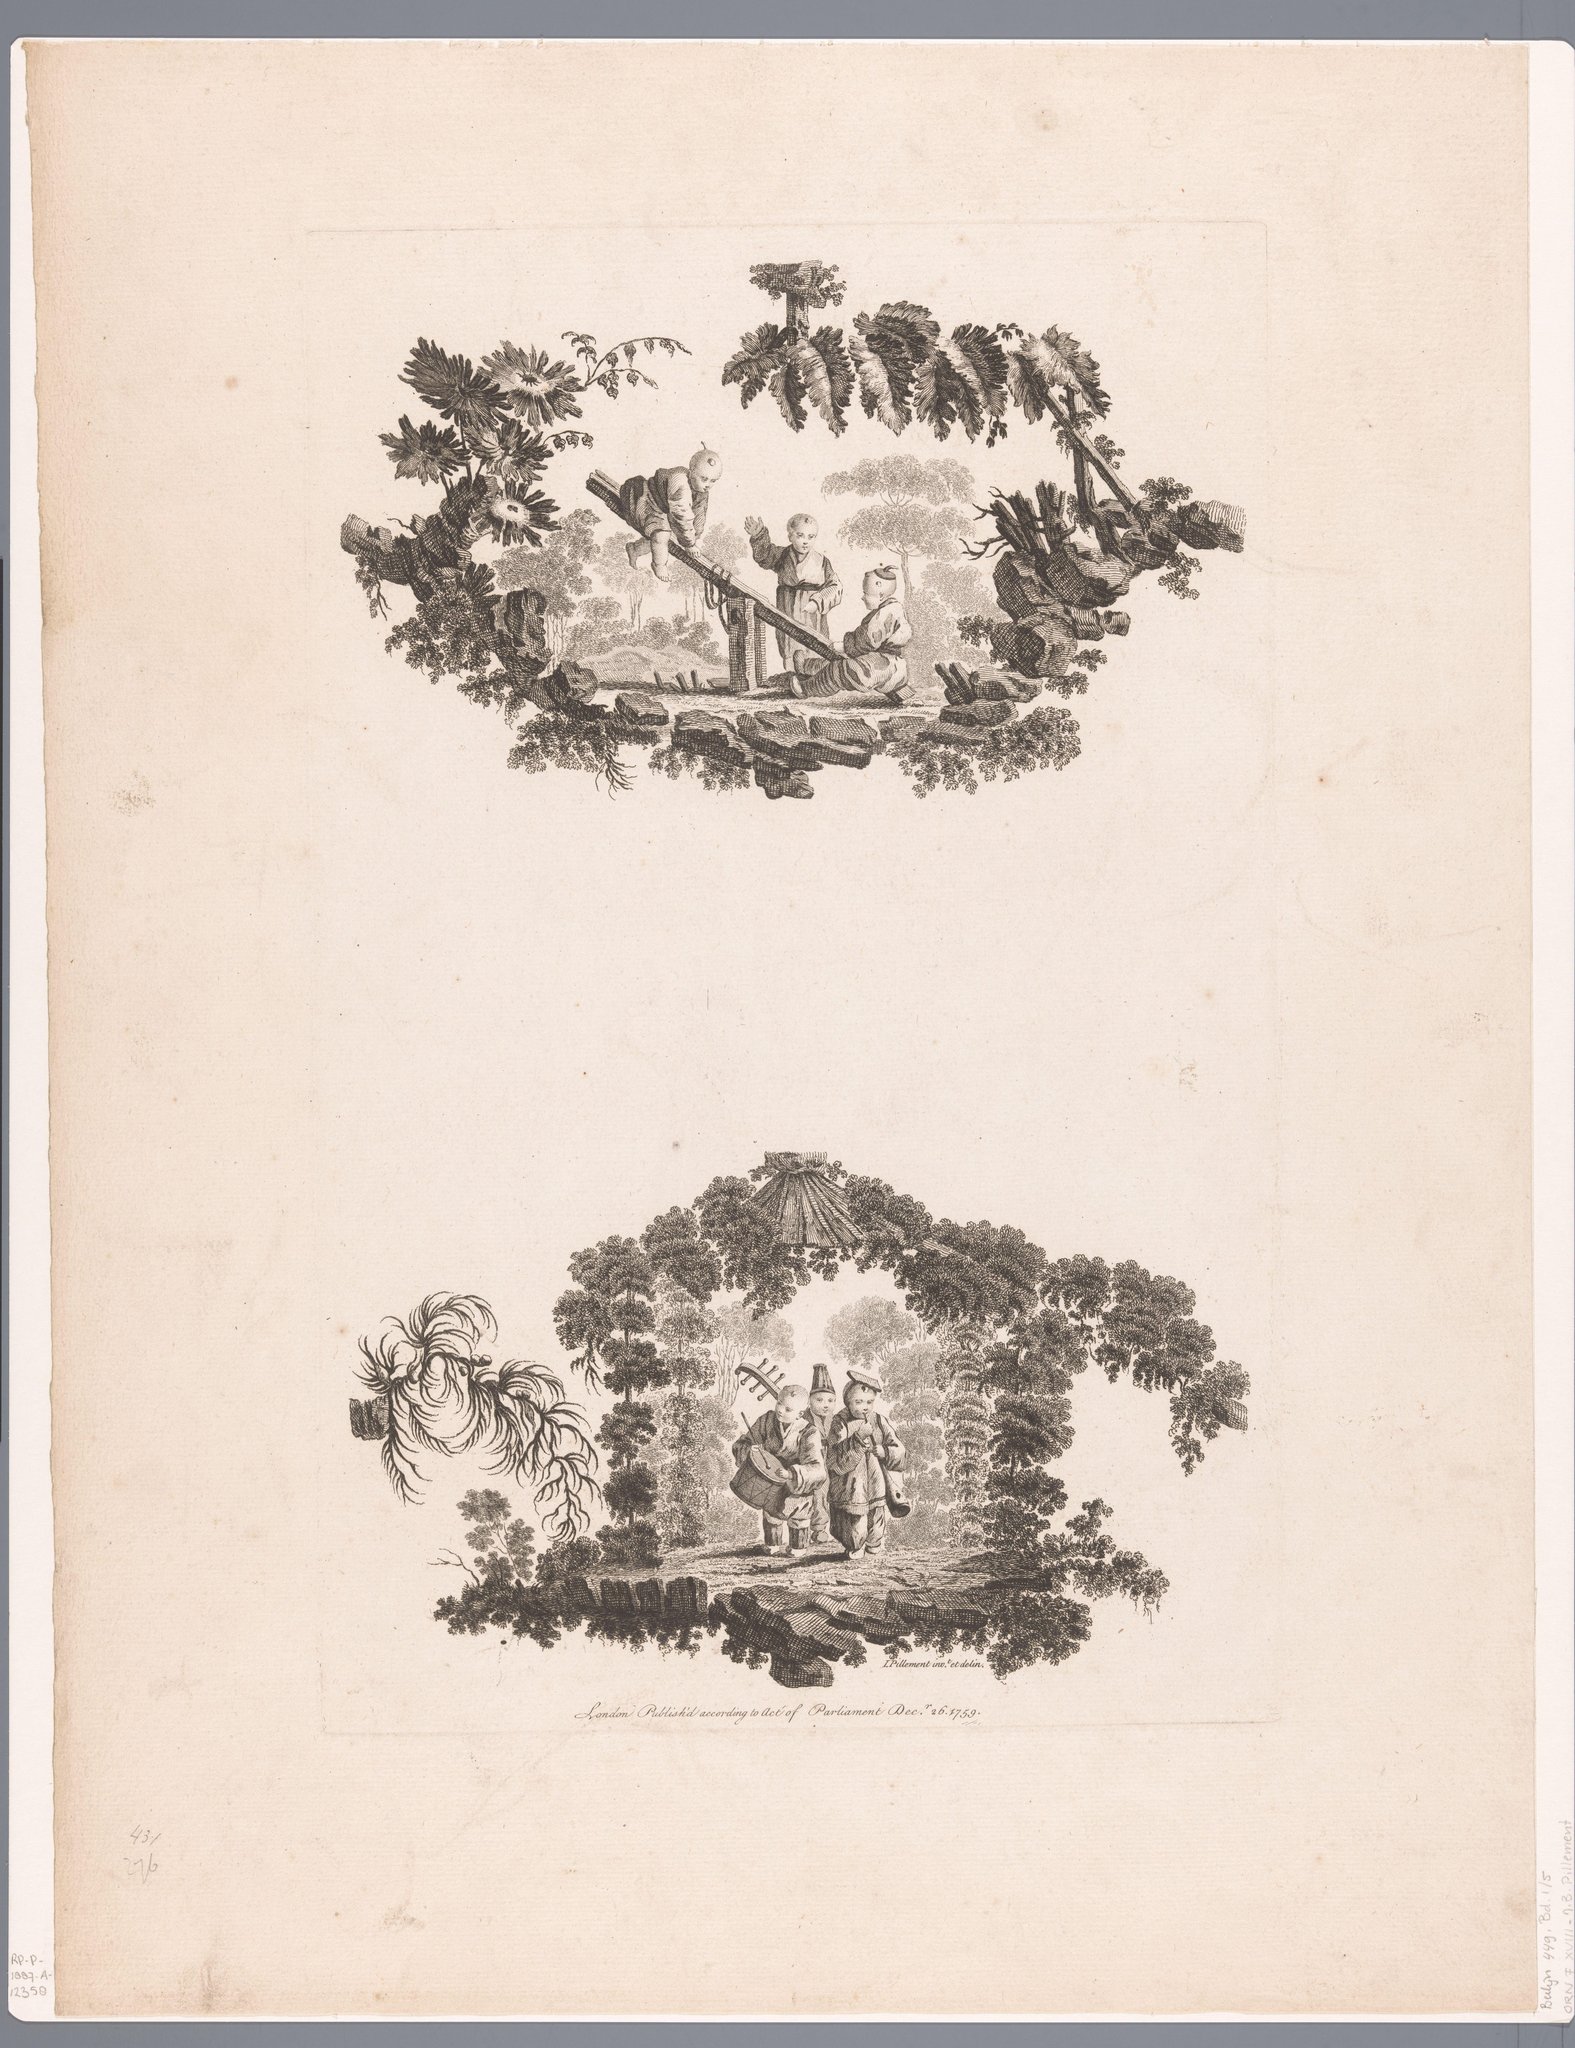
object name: ornament print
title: Kinderen op wip en musicerende kinderen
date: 1759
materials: paper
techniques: etching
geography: london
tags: children's games and plays, more than one musician with instrument, seesaw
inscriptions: collector's mark: Lugt 2228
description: Boven: Twee Chinese kinderen zitten op een wip. Naast de wip staat een derde kind. Onder: Drie Chinese kinderen spelen al lopend op een snaarinstrument, een blaasinstrument en een trommel. Rondom beide voorstellingen een omlijsting met bladeren en bloemen.